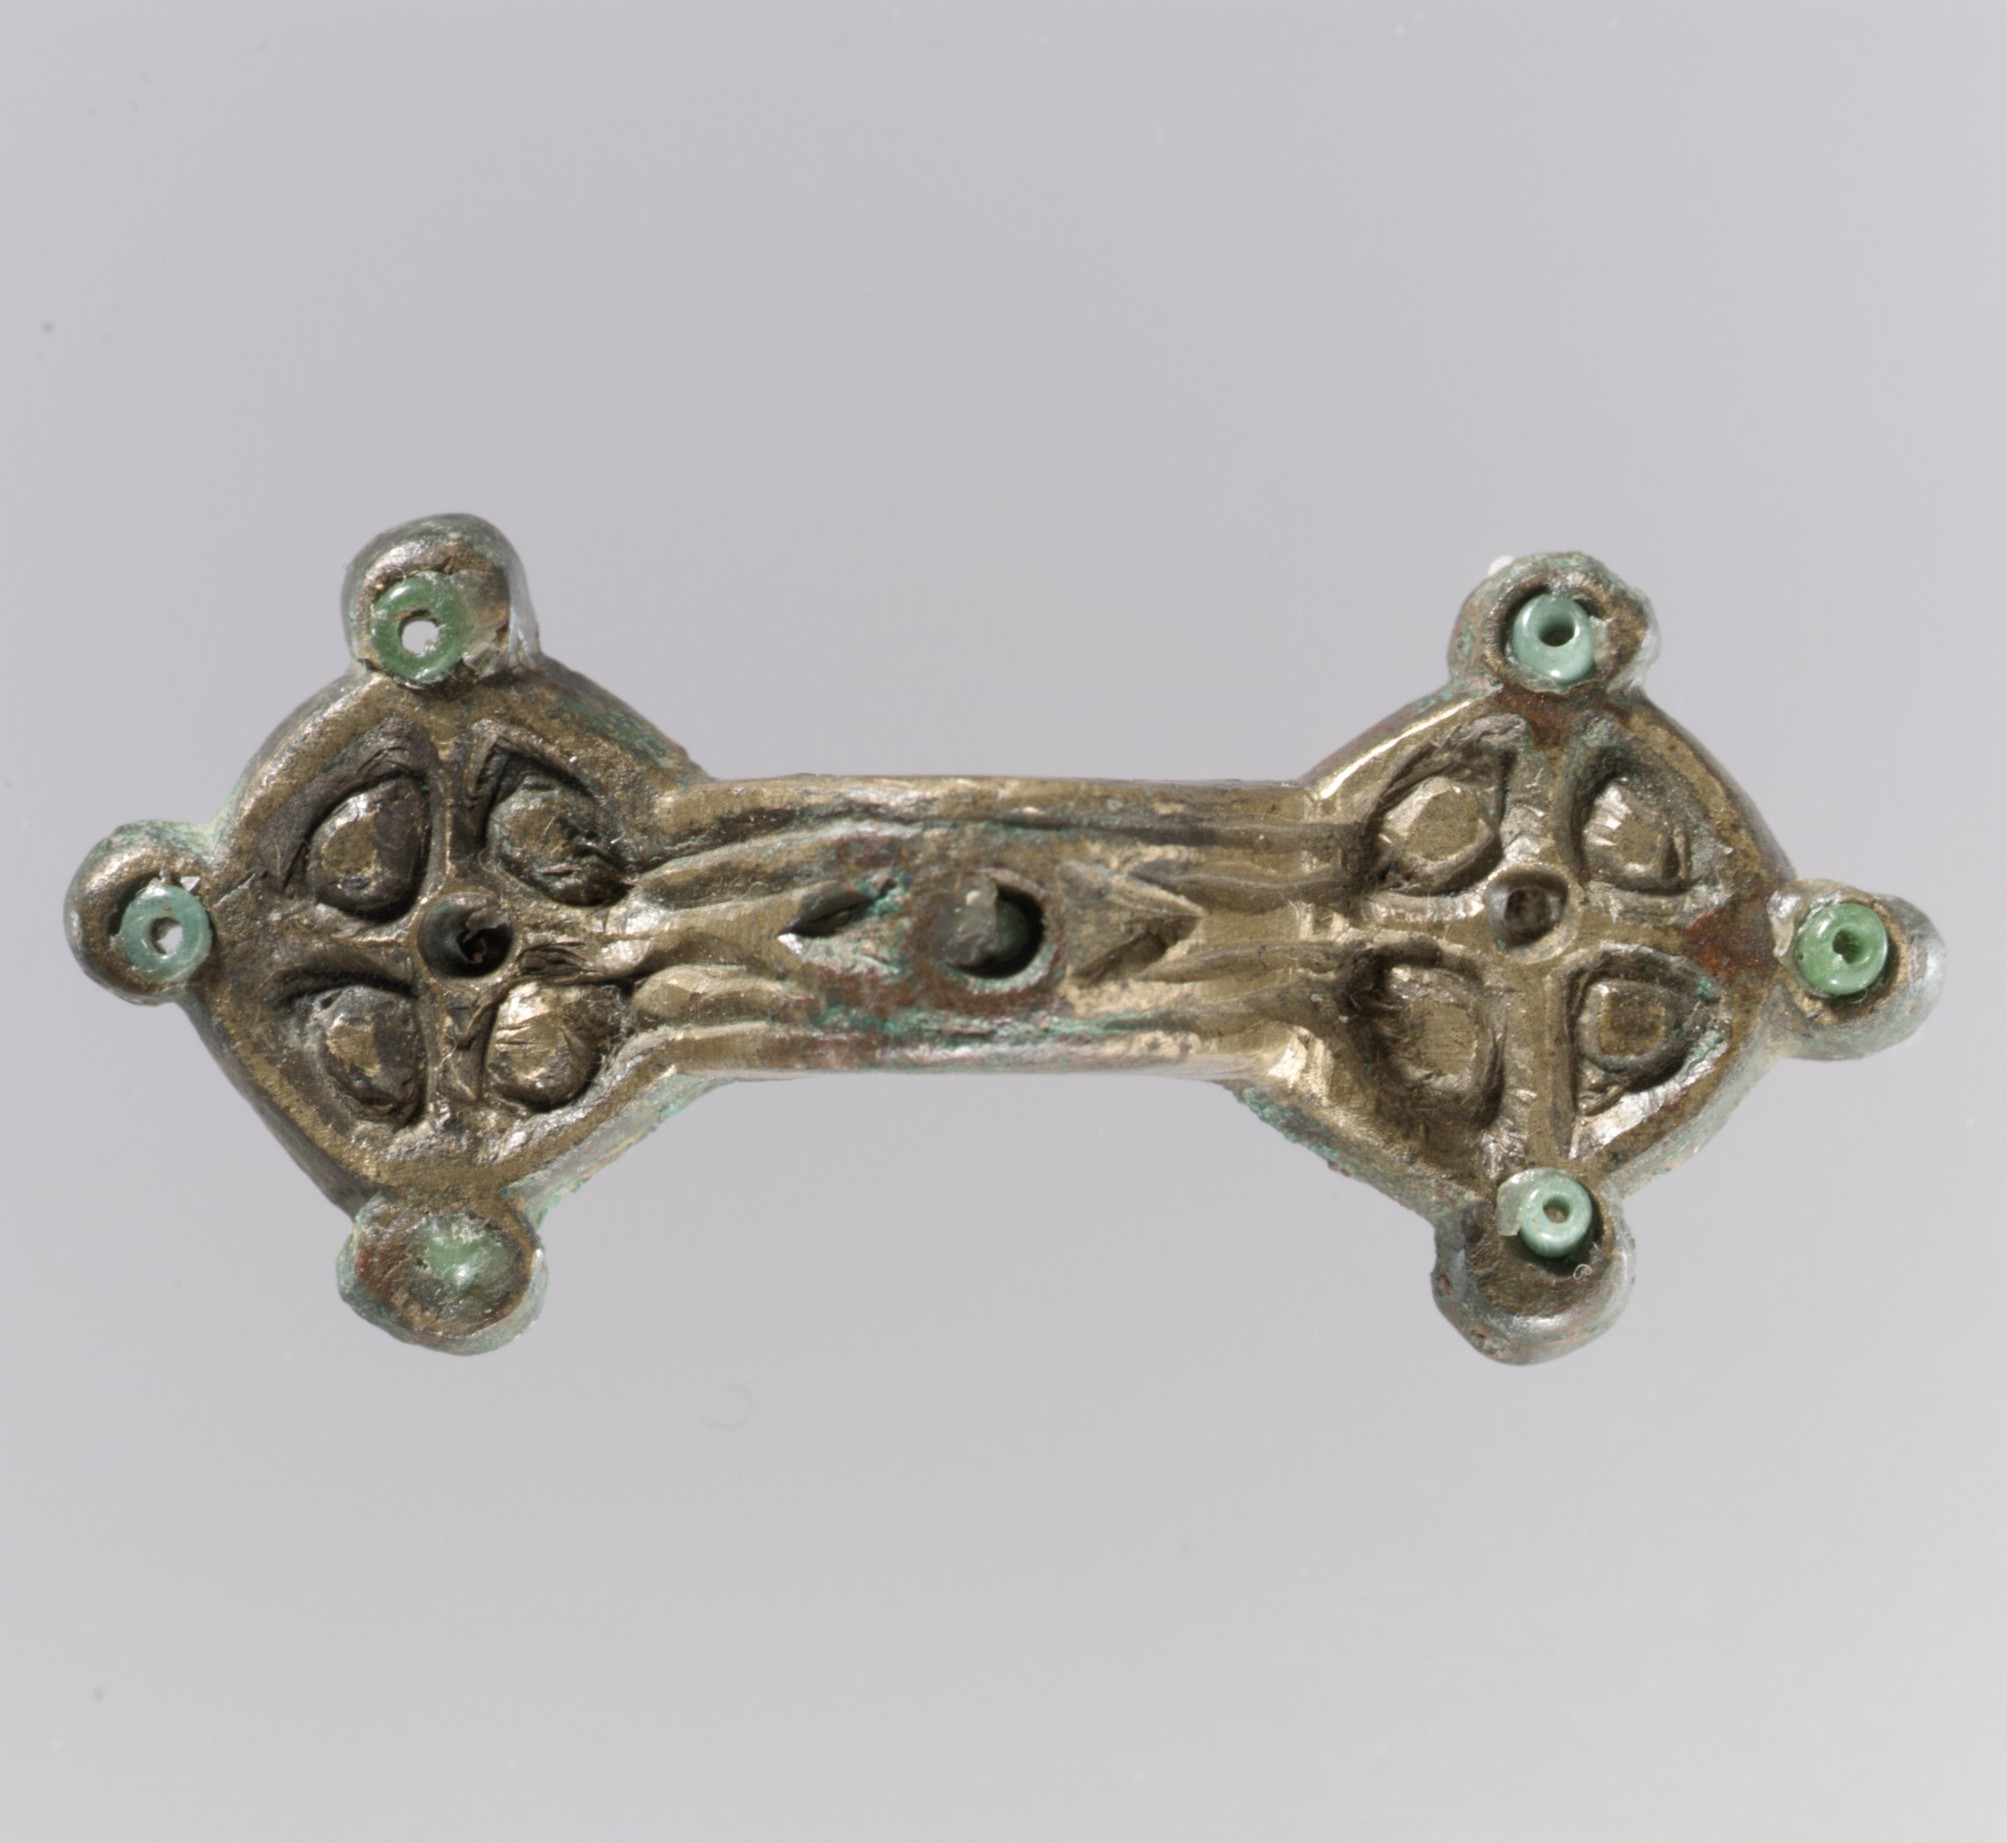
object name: brooch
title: Equal-Arm Brooch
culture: frankish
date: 601-800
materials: copper alloy, glass, wax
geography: france